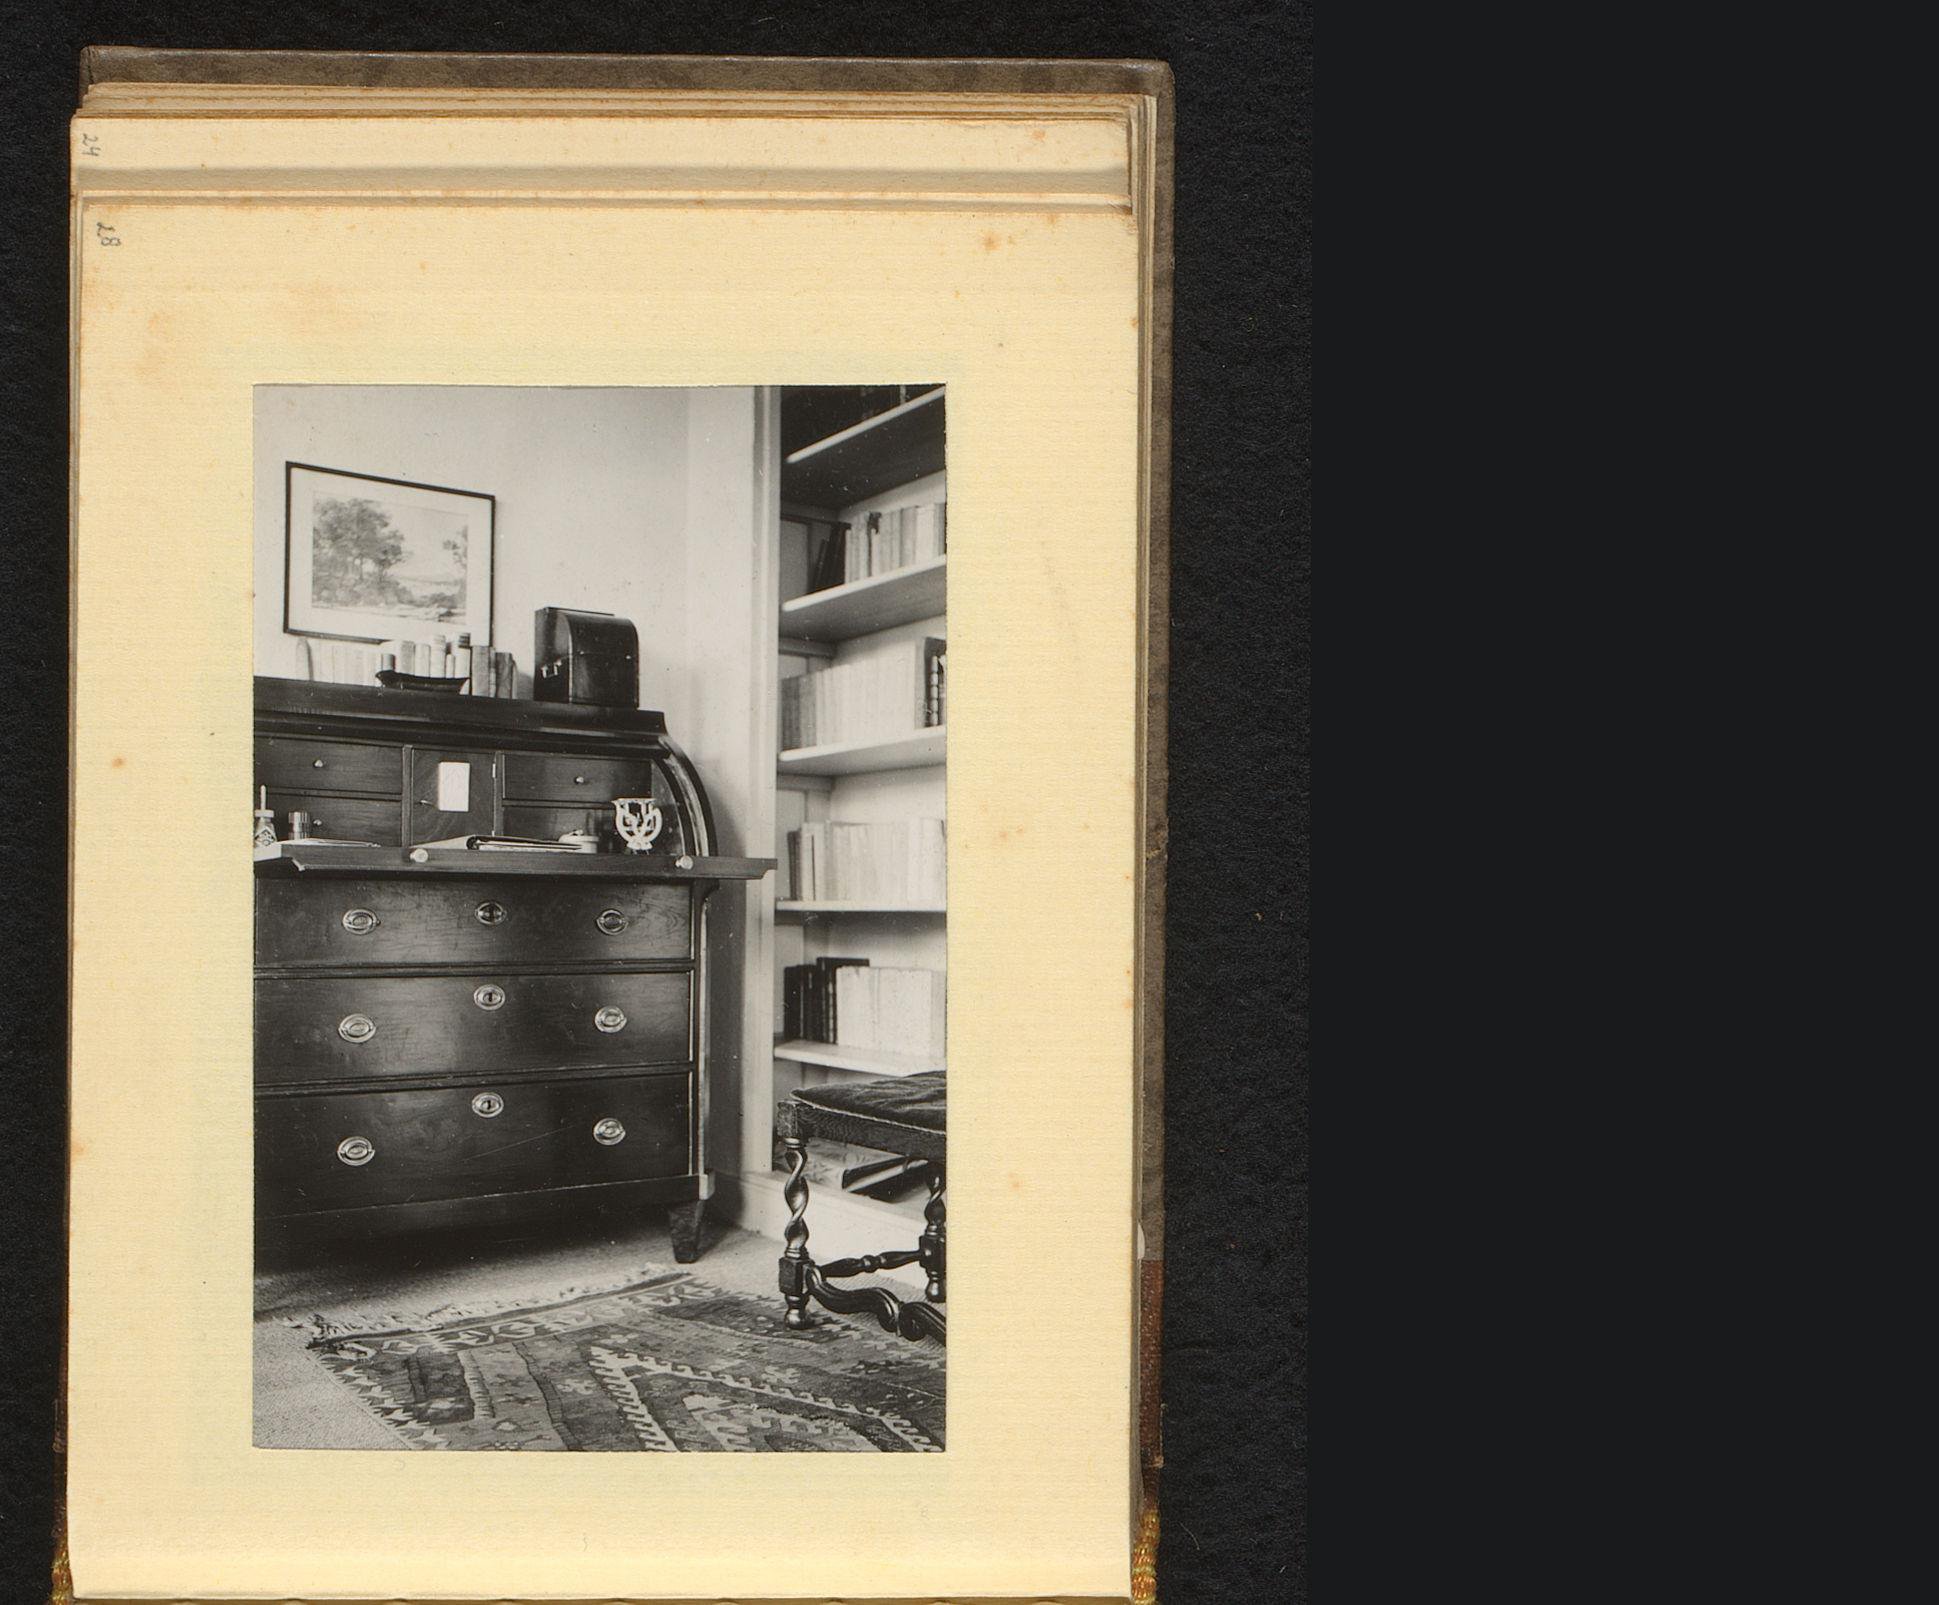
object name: album leaf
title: Interieur met schrijftafel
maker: norbert van den berg (1901-1972)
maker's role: amateurfotograaf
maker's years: 1901-1972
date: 1935-1950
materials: paper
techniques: gelatin silver print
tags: writing-table, writing-desk, interior of the house